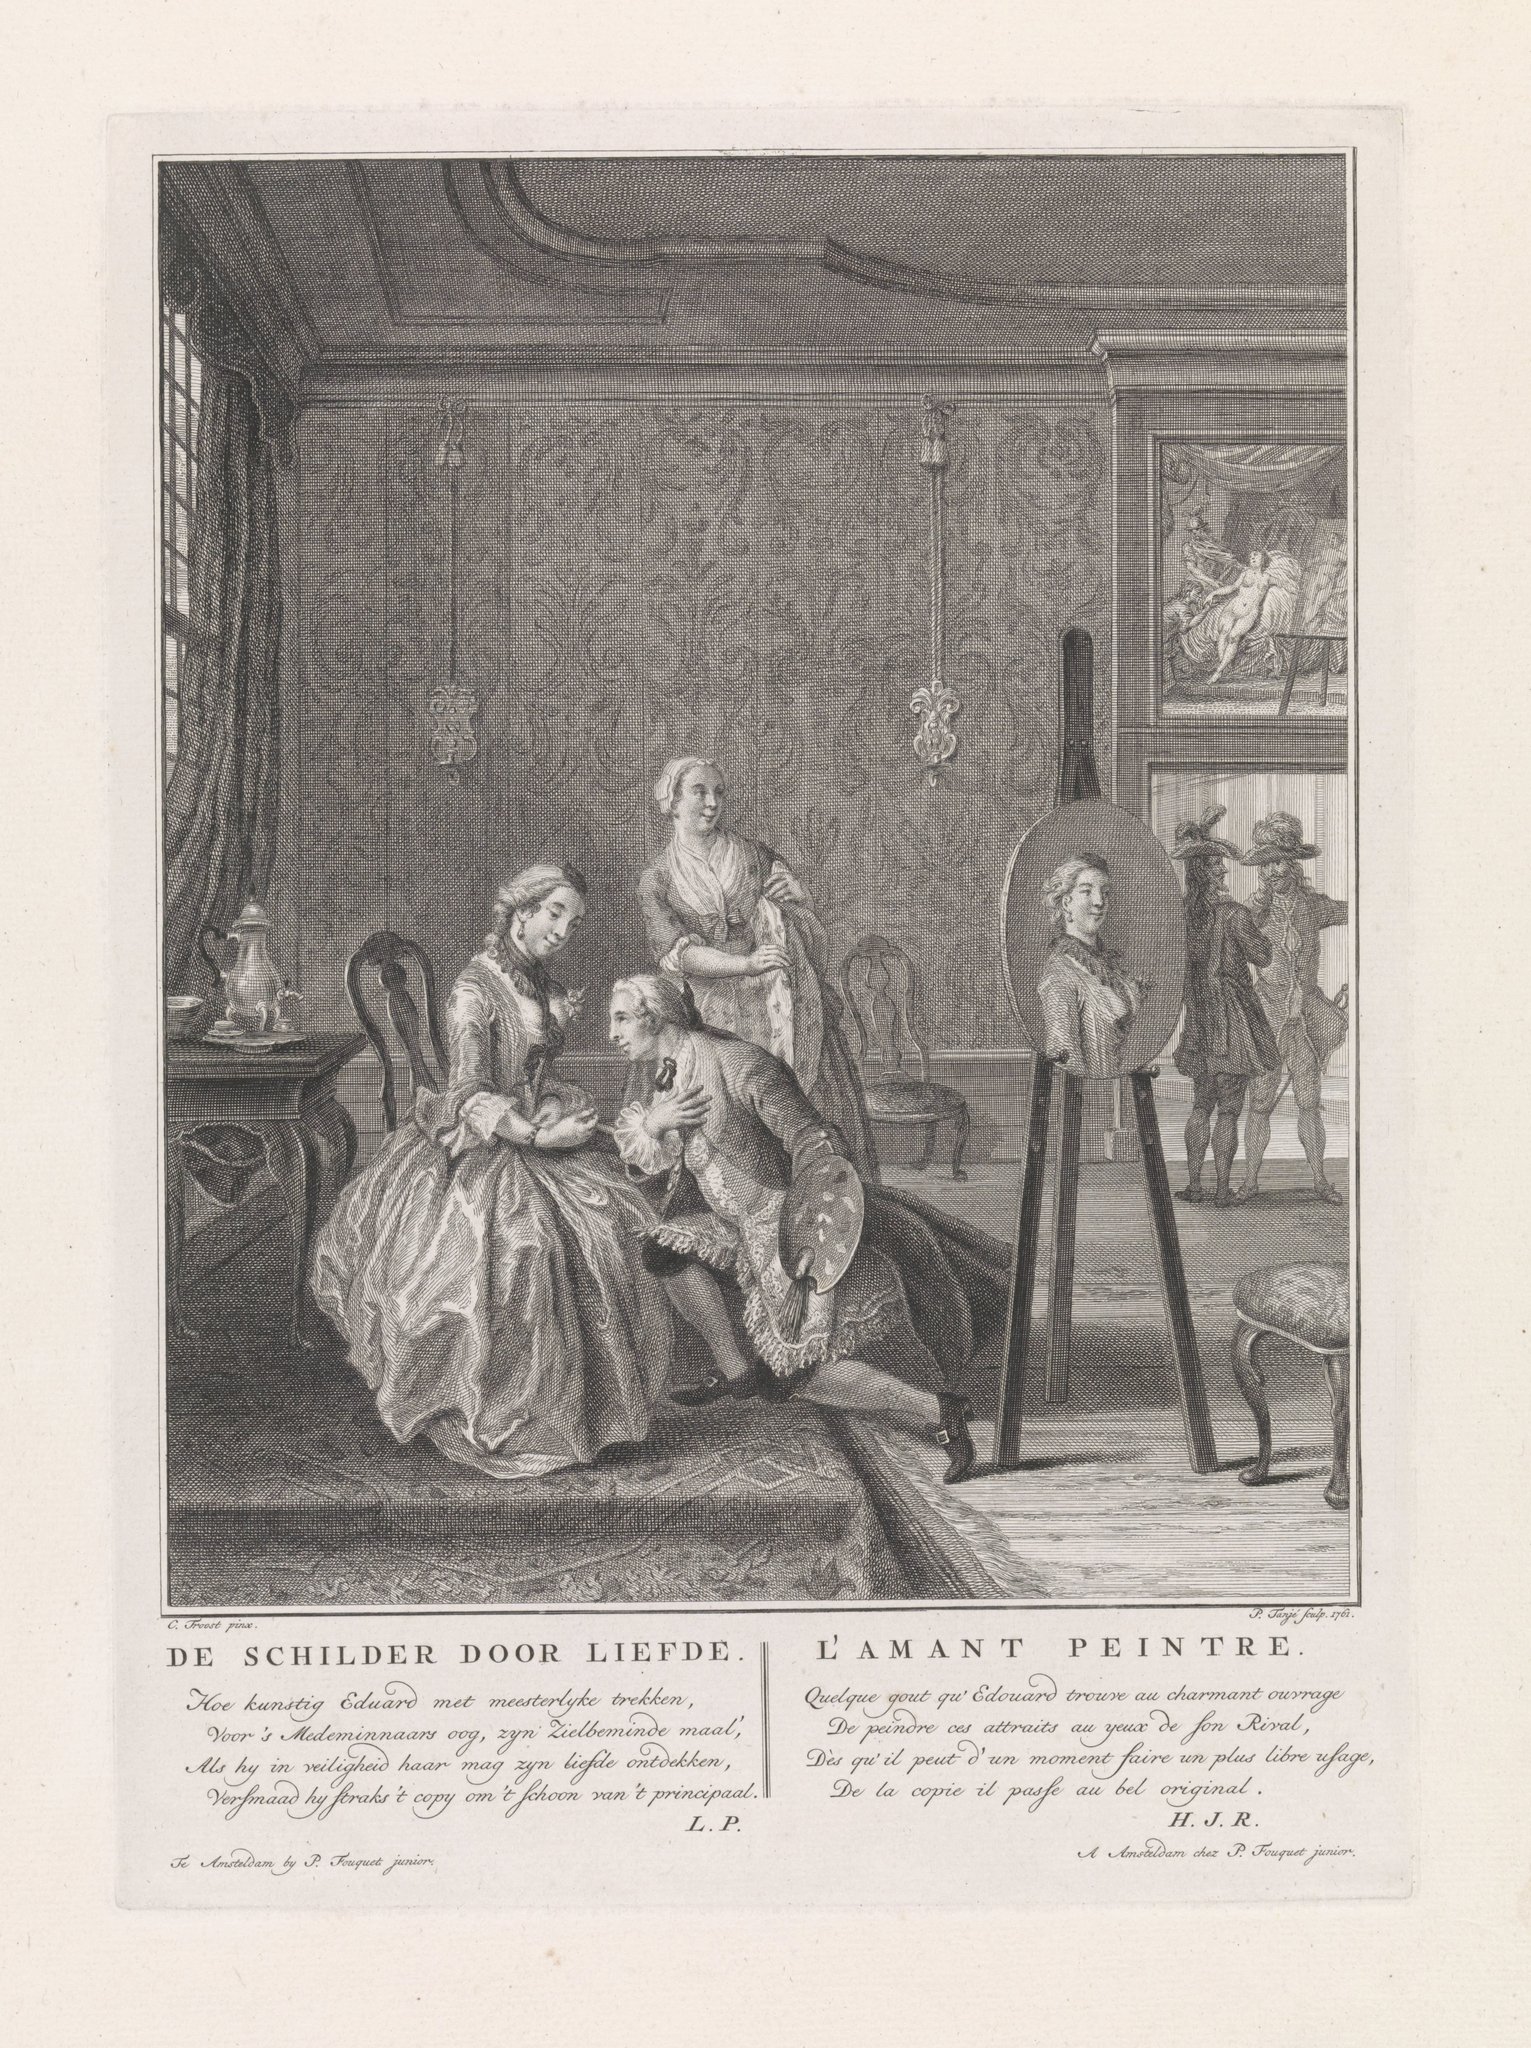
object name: print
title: De schilder door liefde / L'amant peintre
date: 1761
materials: paper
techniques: engraving, etching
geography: amsterdam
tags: kneeling figure, apelles paints campaspe and falls in love with her; alexander yields her to him, painter working from clothed model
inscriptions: collector's mark: Lugt 2233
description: De schilder Eduard verklaart Leonoor, wiens portret hij vervaardigd heeft, zijn liefde. Bij de deur staat Leonoor's jaloerse man Don Pedro, die door de schildersknecht bezig wordt gehouden. Boven de deur hangt een schilderij met een voorstelling van Alexander, die de schilder Apelles zijn minnares Campaspe ten geschenke geeft. Onderaan in de marge een vierregelig vers in het Nederlands en het Frans. Scène uit het tweede bedrijf van het toneelstuk De schilder door liefde, van Molière.